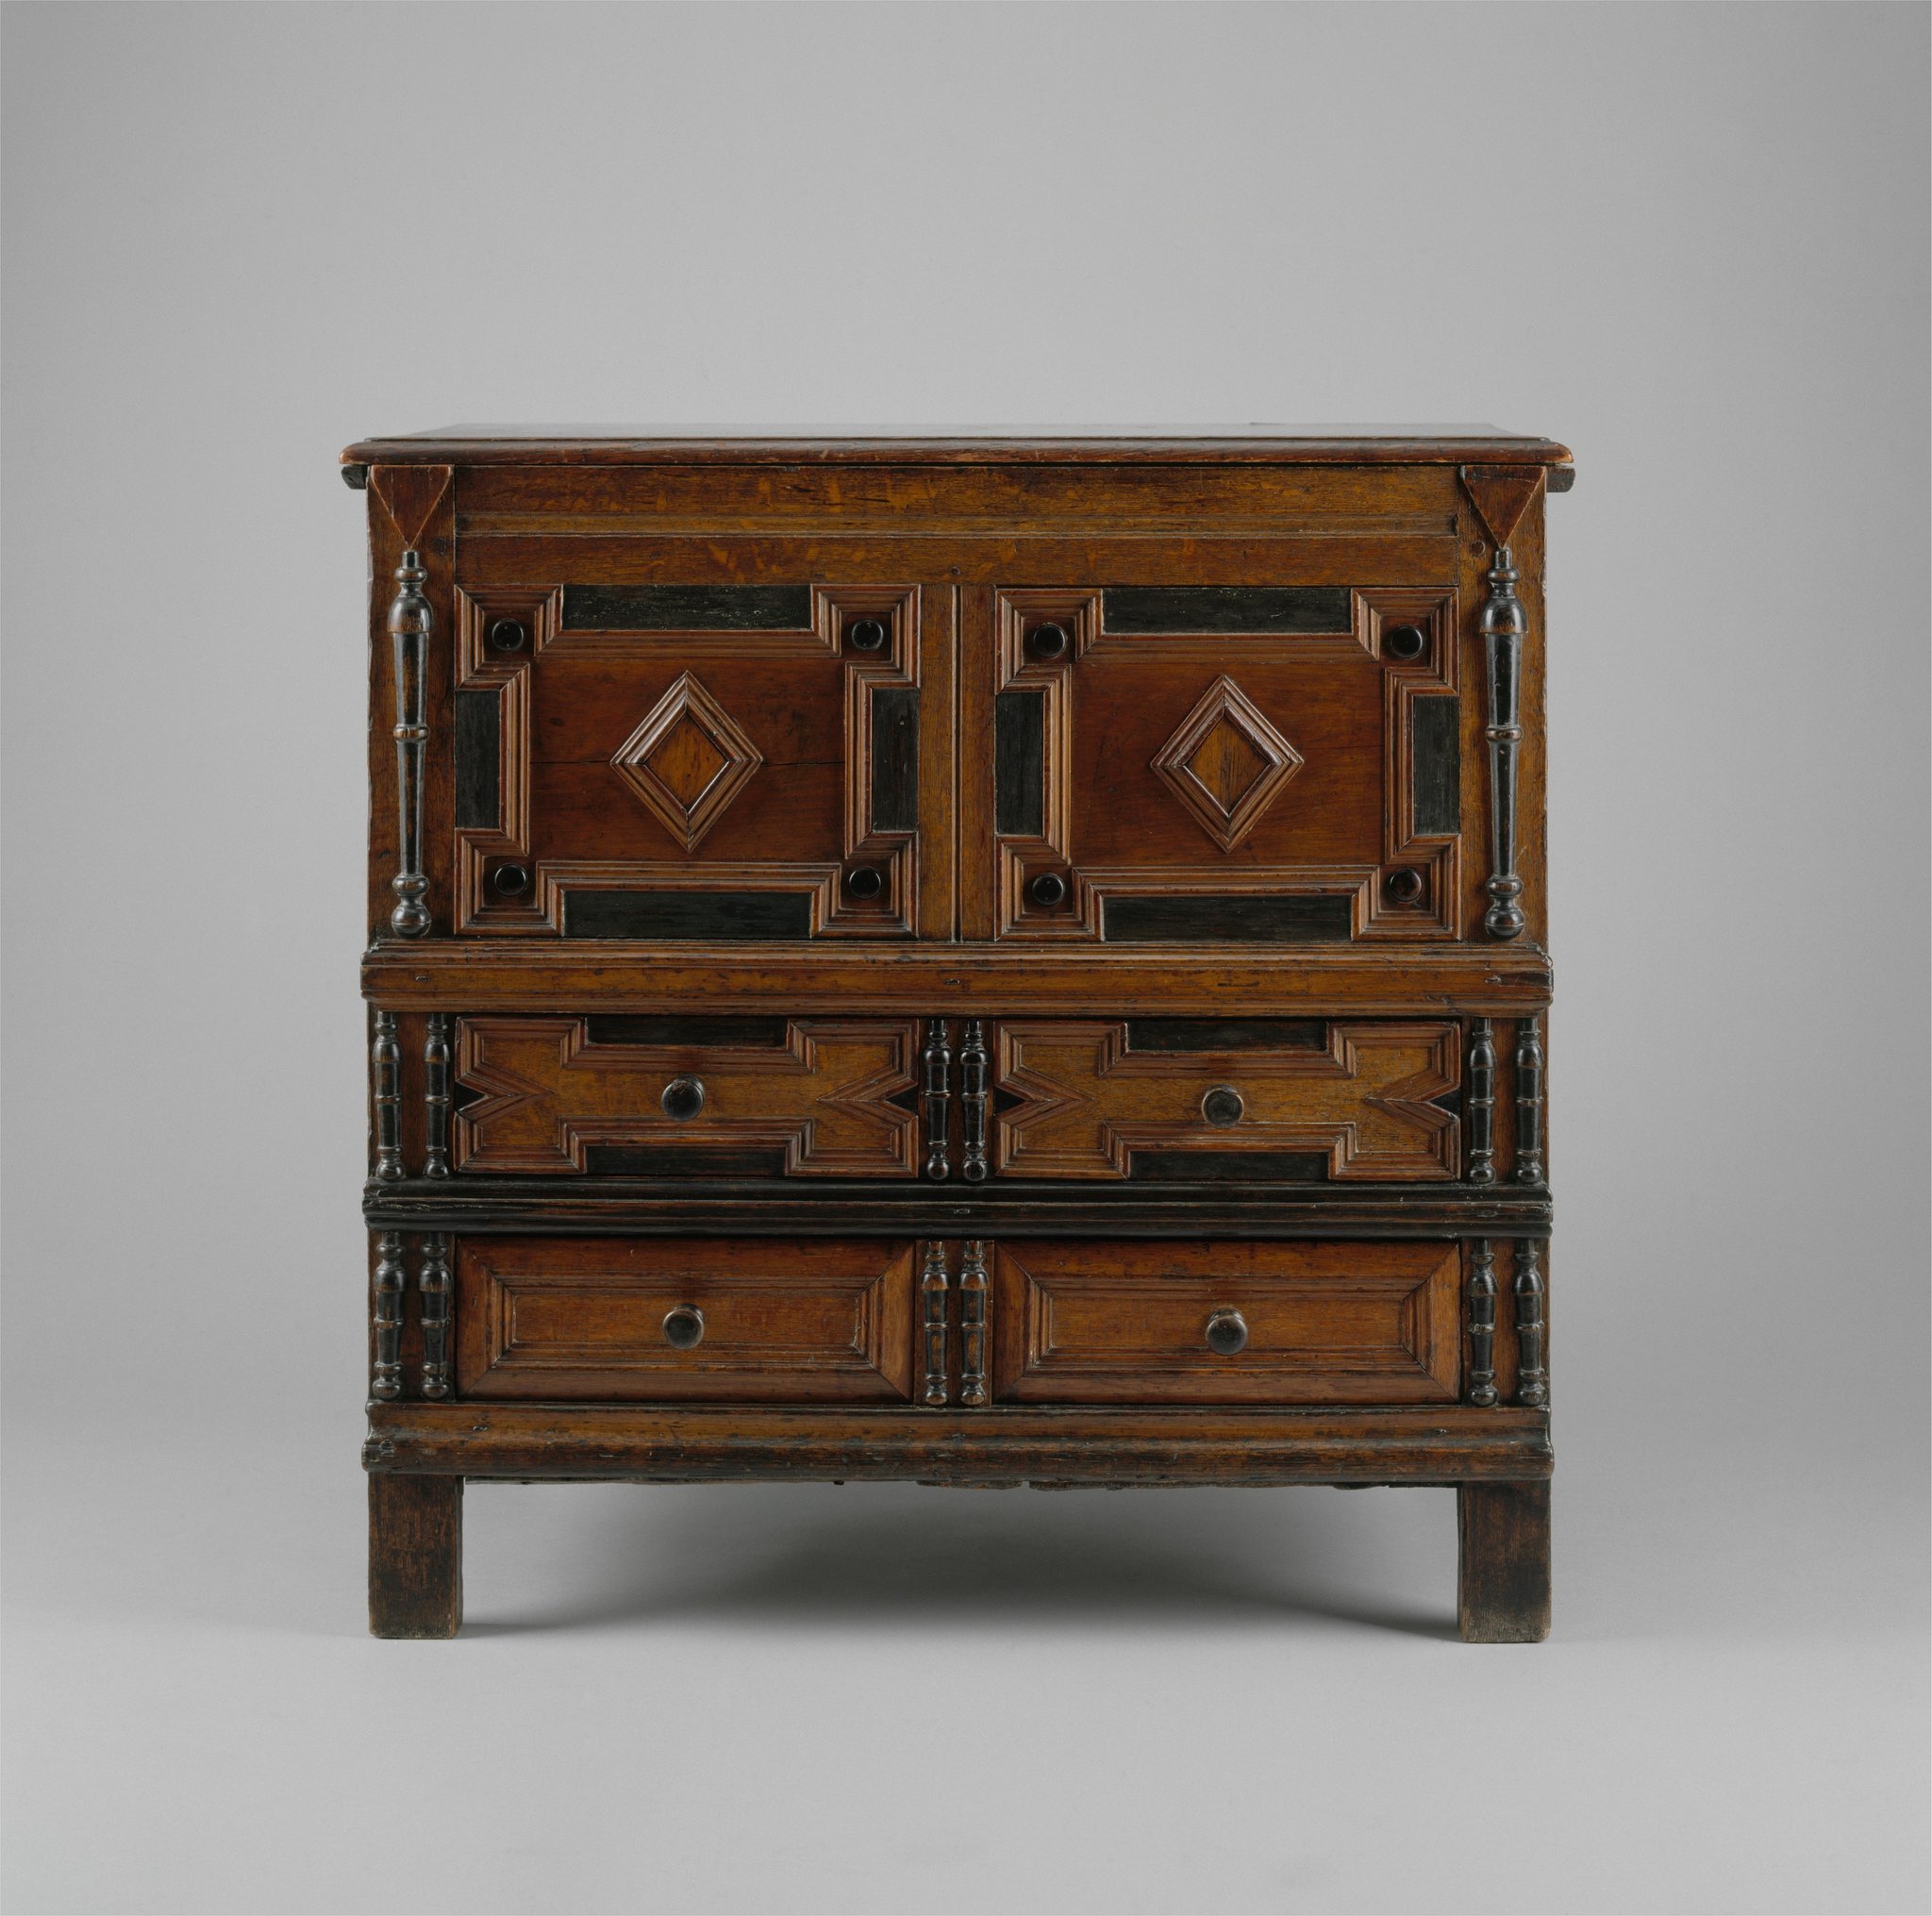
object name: chest of drawer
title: Chest with Drawers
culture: american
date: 1670-1700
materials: wood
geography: united states